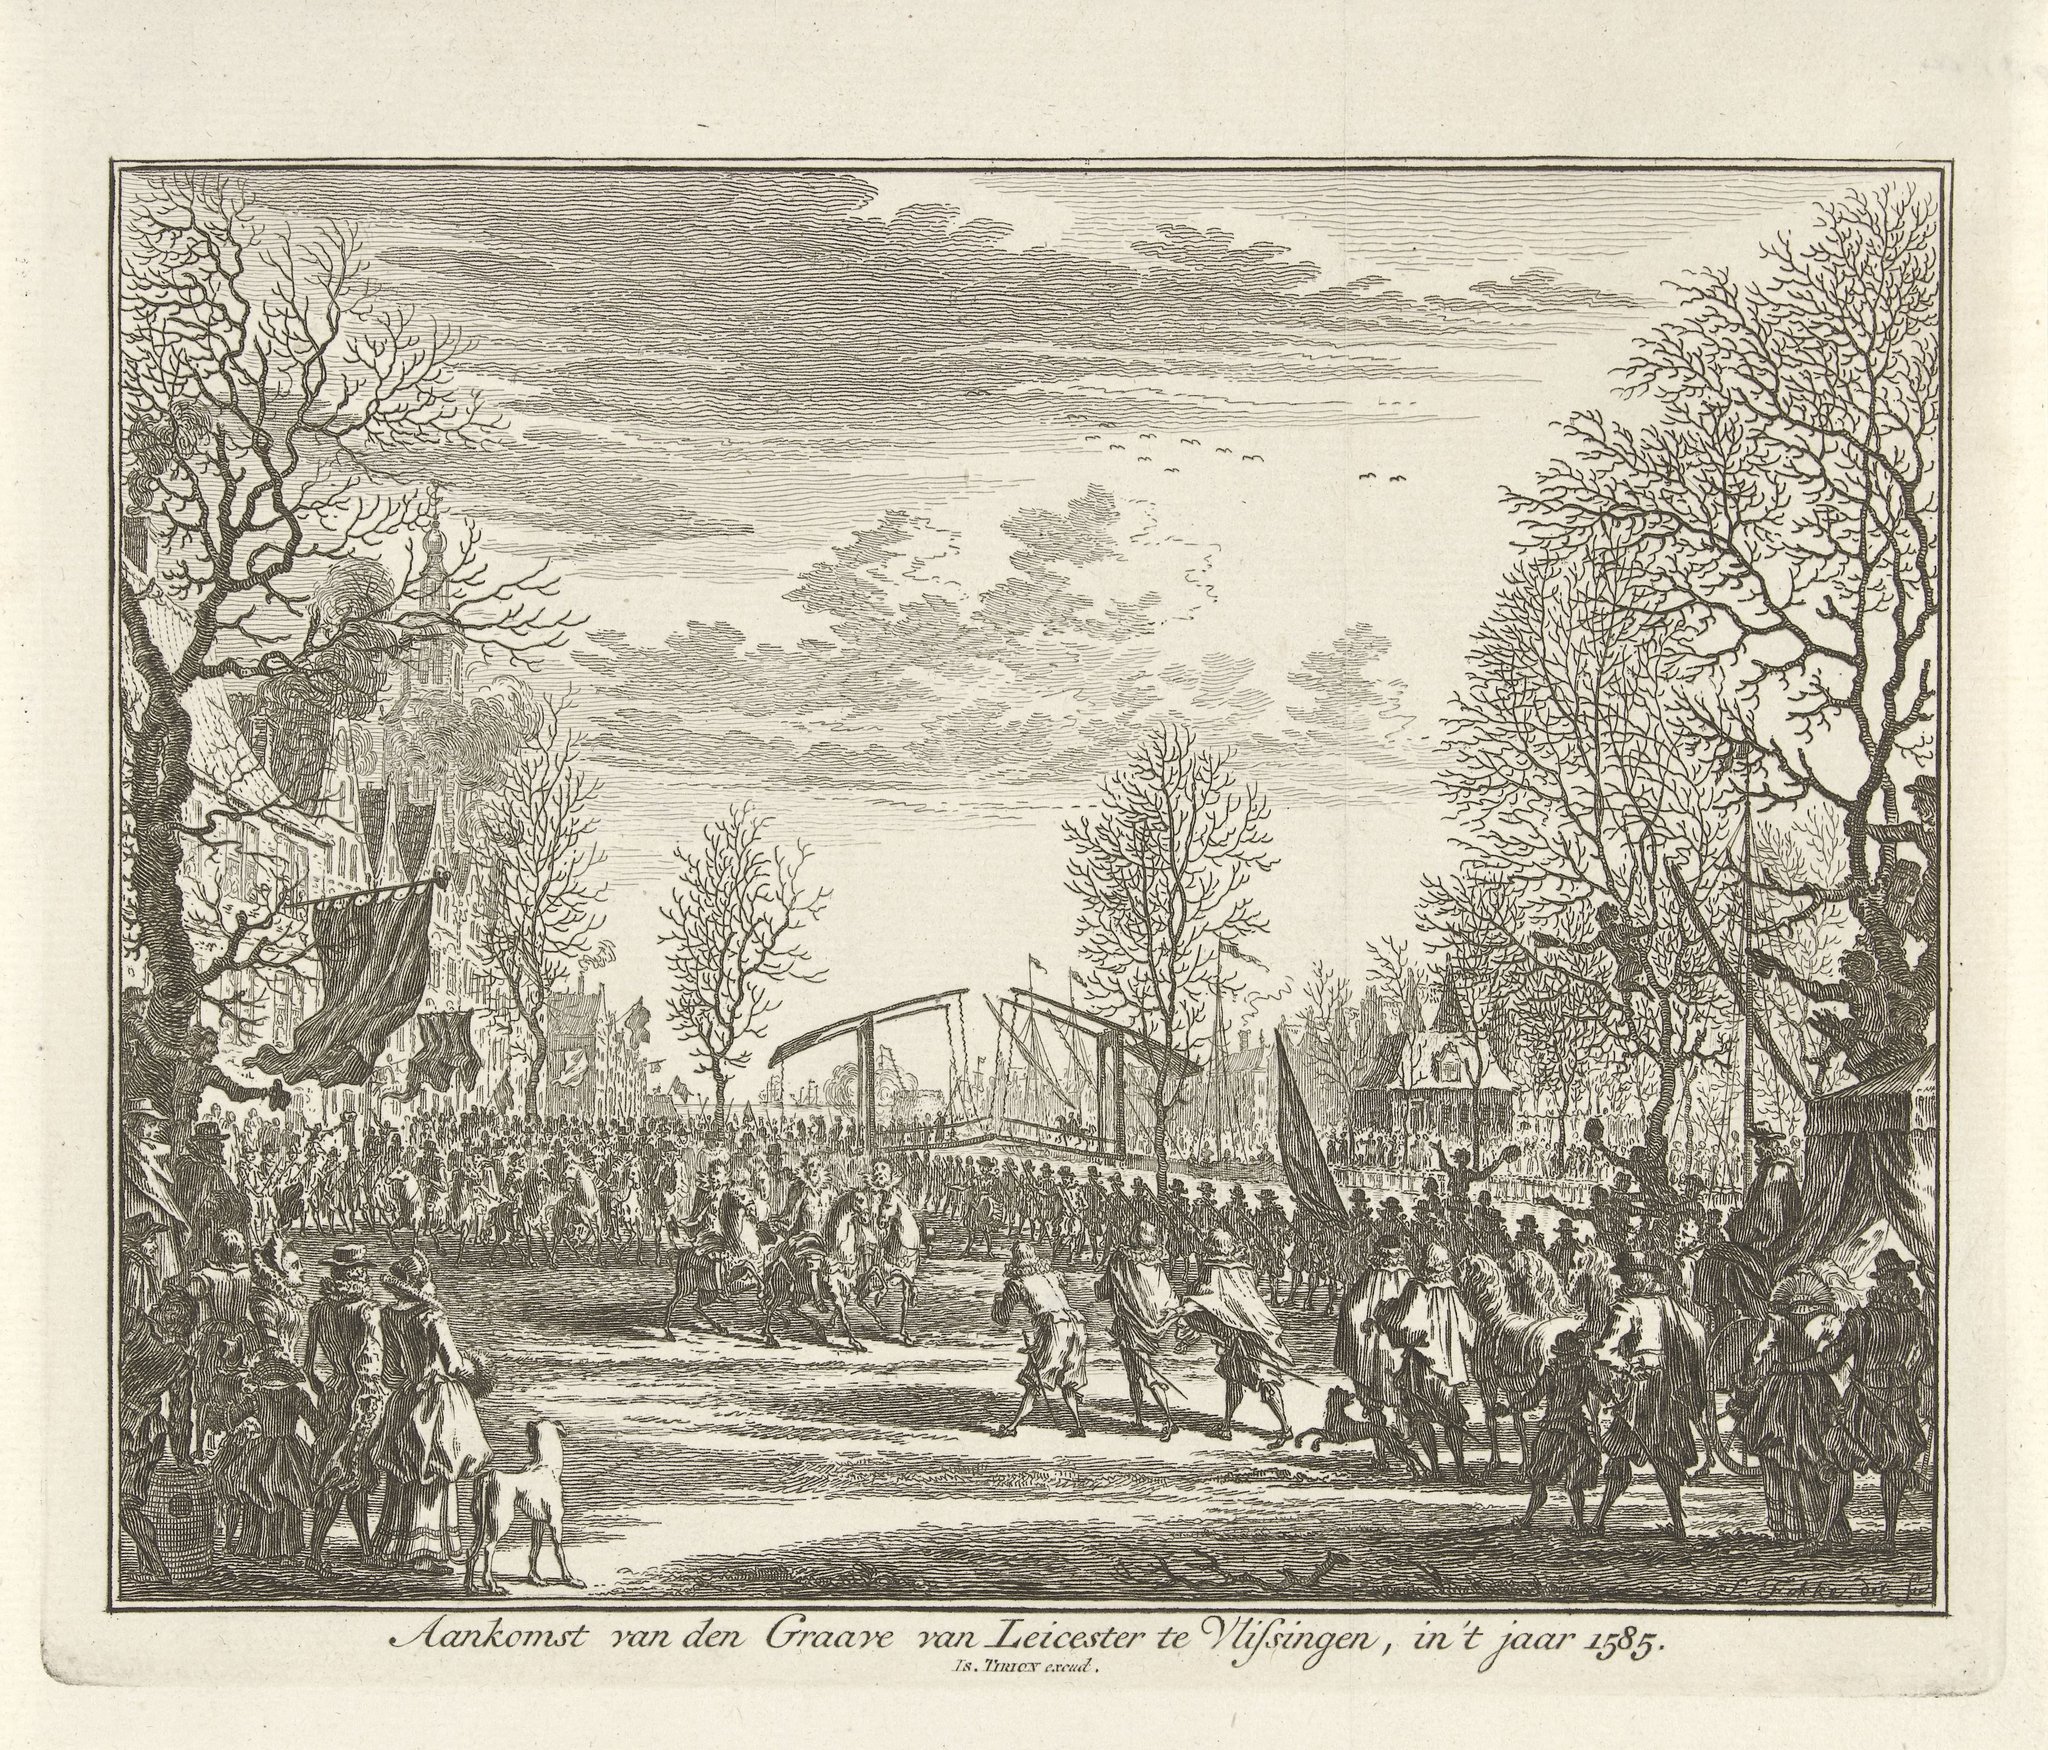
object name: print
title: Aankomst van den Graave van Leicester te Vlissingen, in 't jaar 1585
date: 1729-1766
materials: paper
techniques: etching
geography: amsterdam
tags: robert dudley (1st earl of leicester), being welcomed ~ travelling, flushing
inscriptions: collector's mark: Lugt 2228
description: Groots onthaal van de graaf van Leicester in Vlissingen. Een menigte soldaten en burgers wonen zijn aankomst bij.